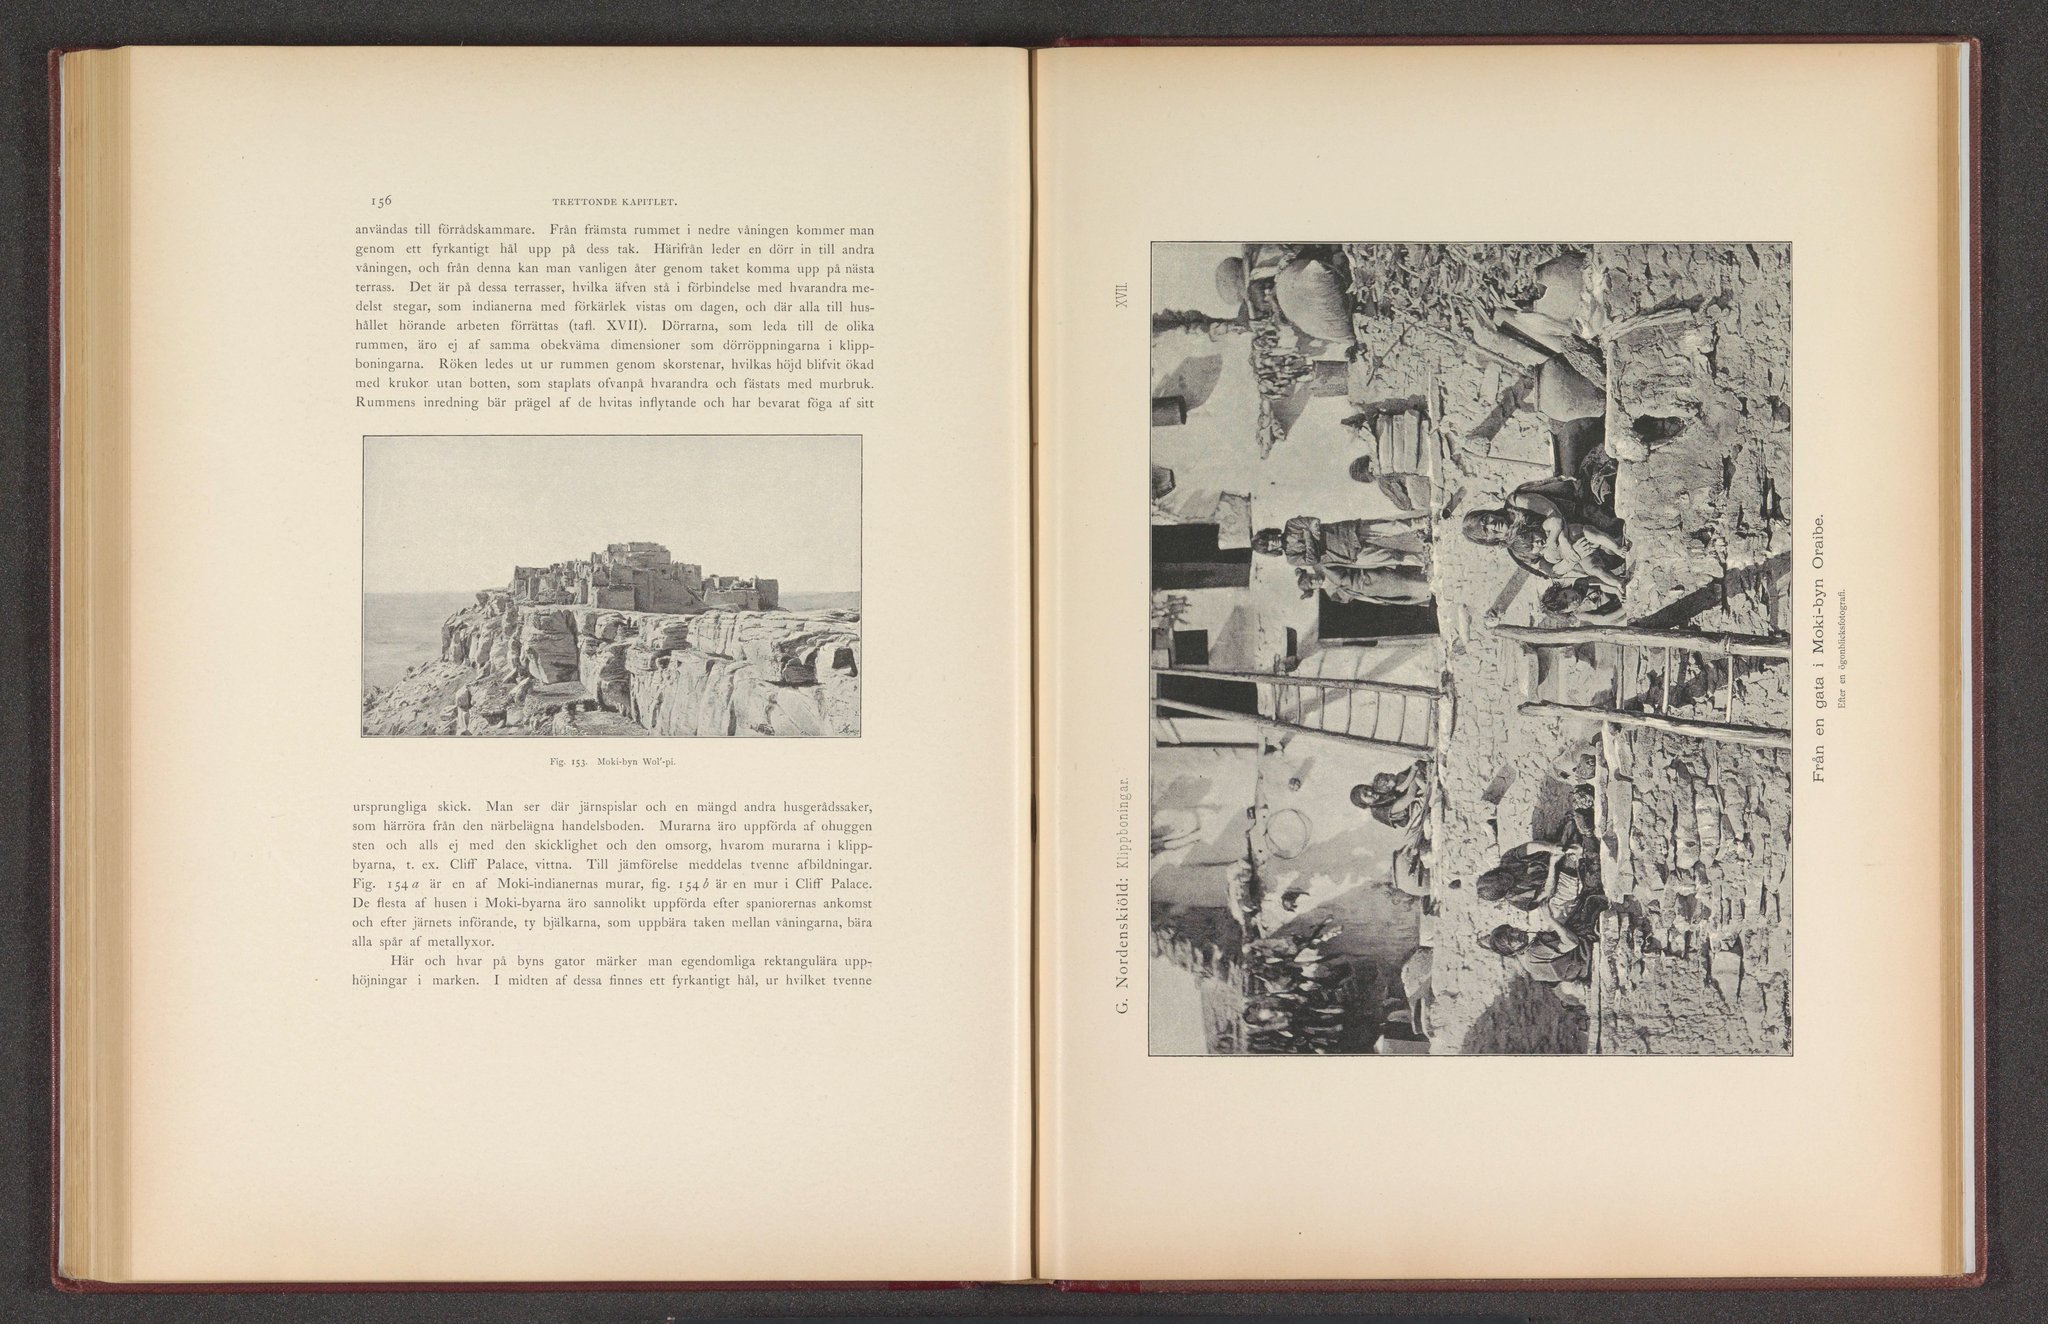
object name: photomechanical print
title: Från en gata i Moki-byn Oraibe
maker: gustaf nordenskiöld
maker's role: fotograaf, schrijver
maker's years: 1868-1895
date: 1891-1893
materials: paper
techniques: autotype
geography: vienna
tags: asiatic races and peoples: indians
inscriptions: inscription: ‘G. Nordenskiöld: Klippboningar.’, number: ‘XVII.’